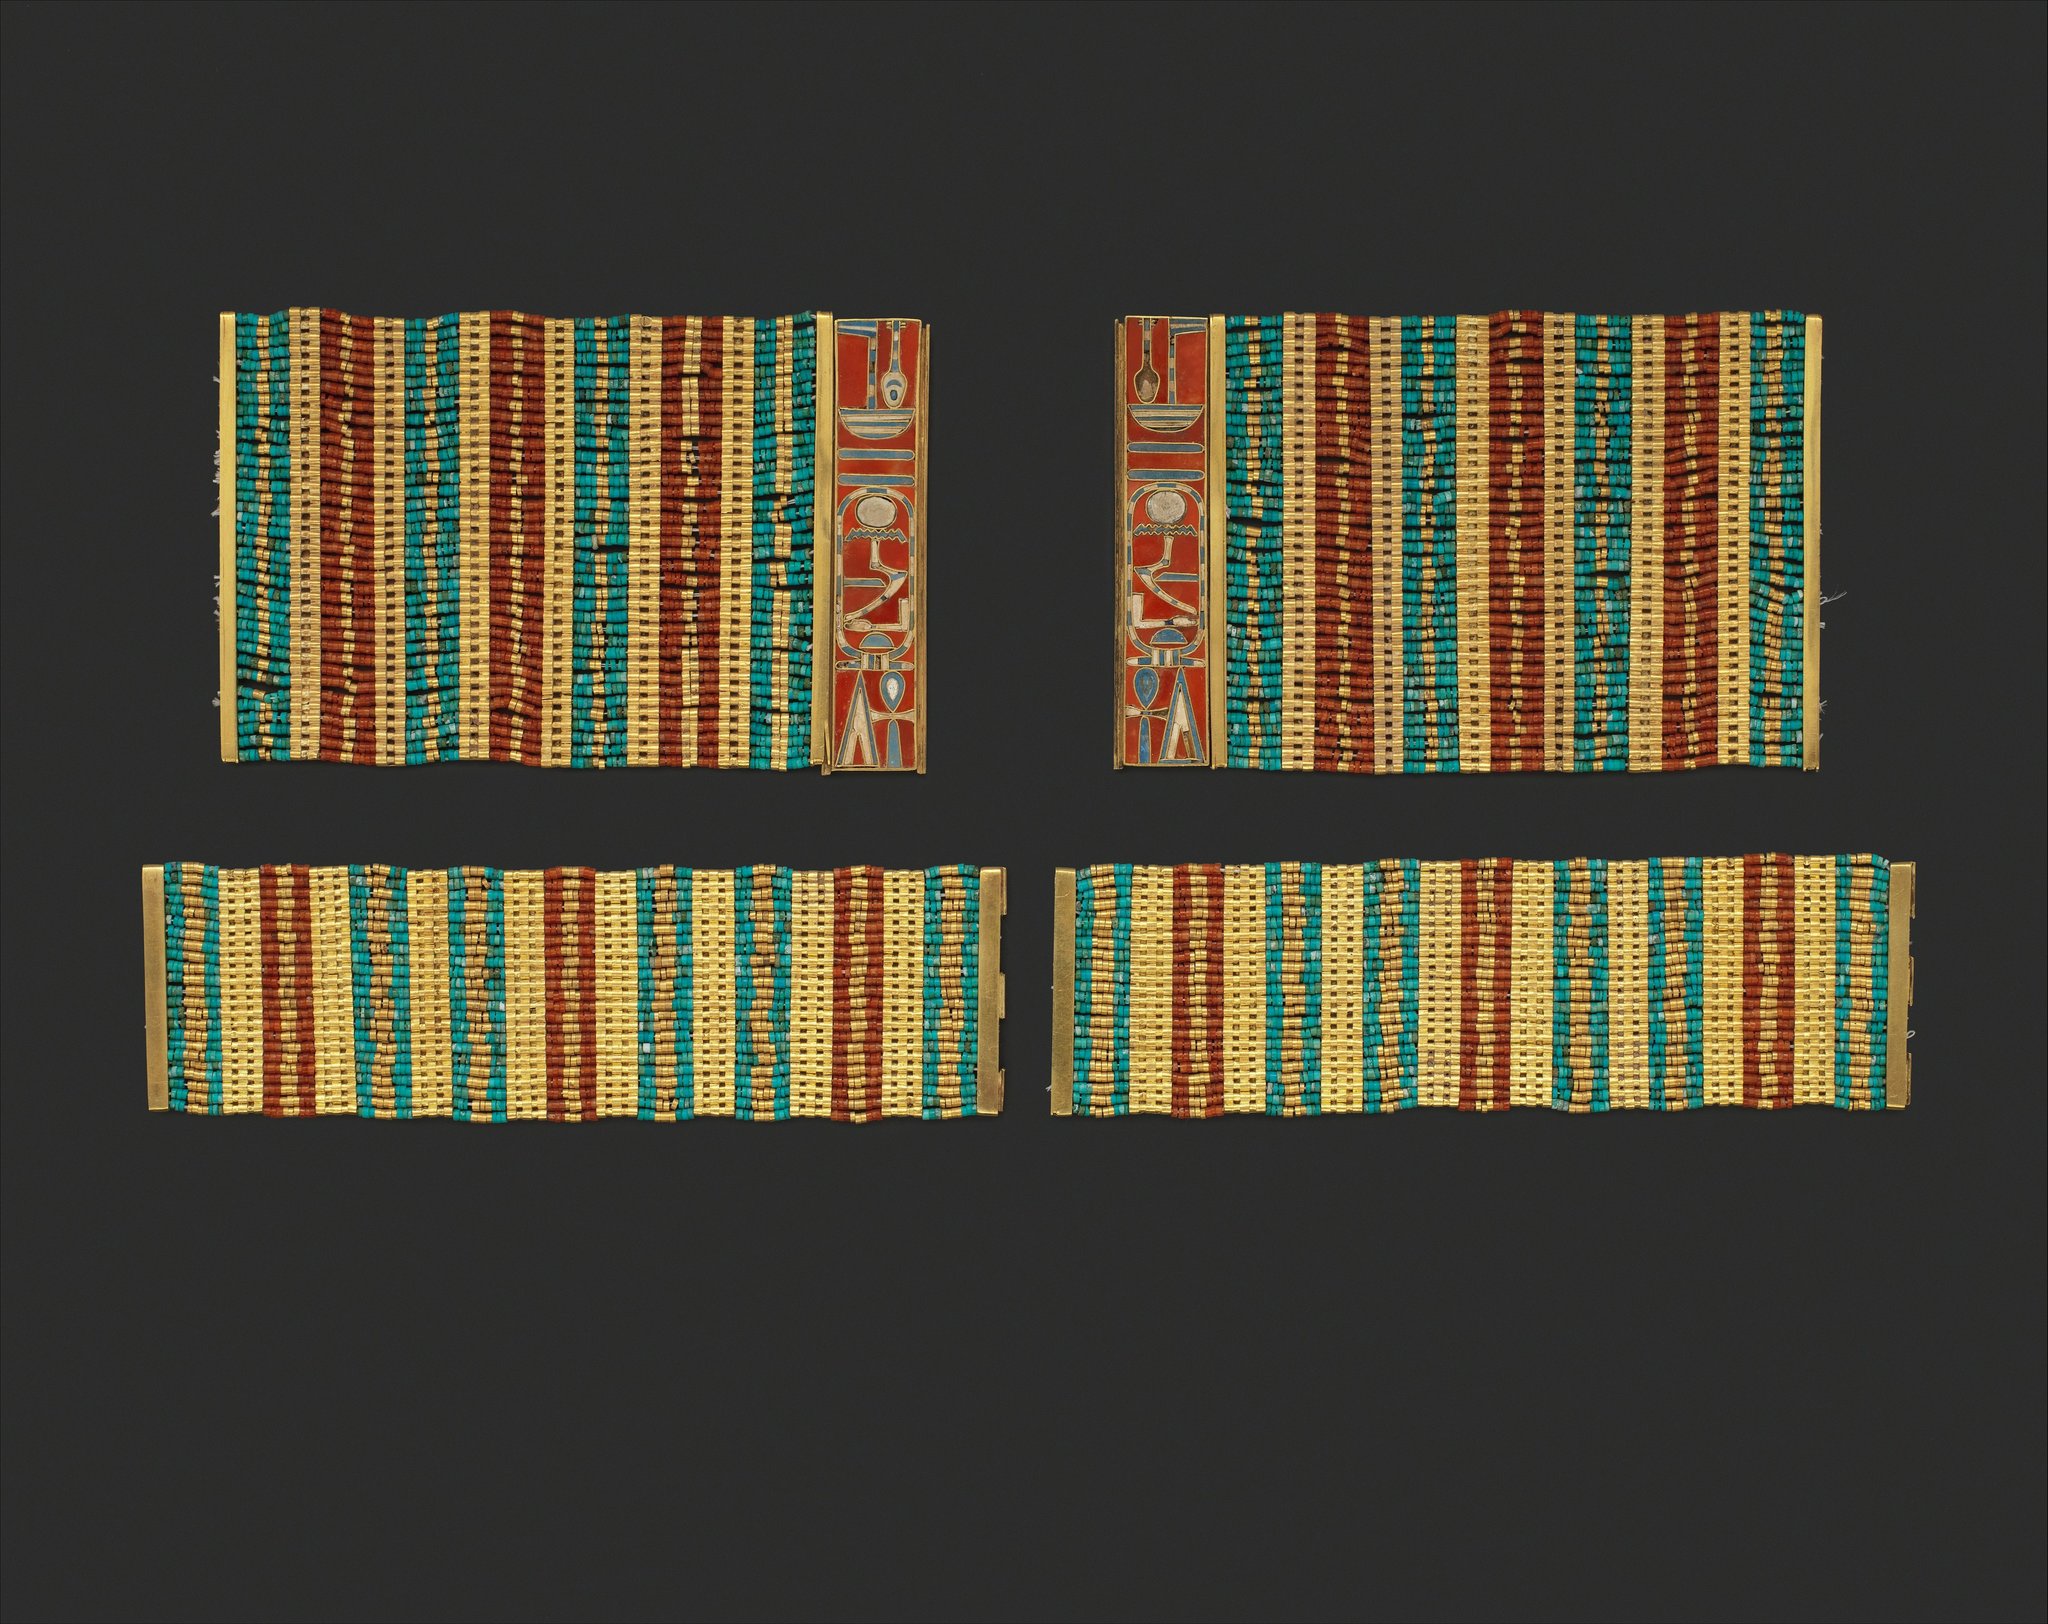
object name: bracelet, sithathoryunet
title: Broad Bracelet of Sithathoryunet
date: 1887-1813 BCE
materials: gemstone, faience, gold, lapis lazuli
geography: egypt